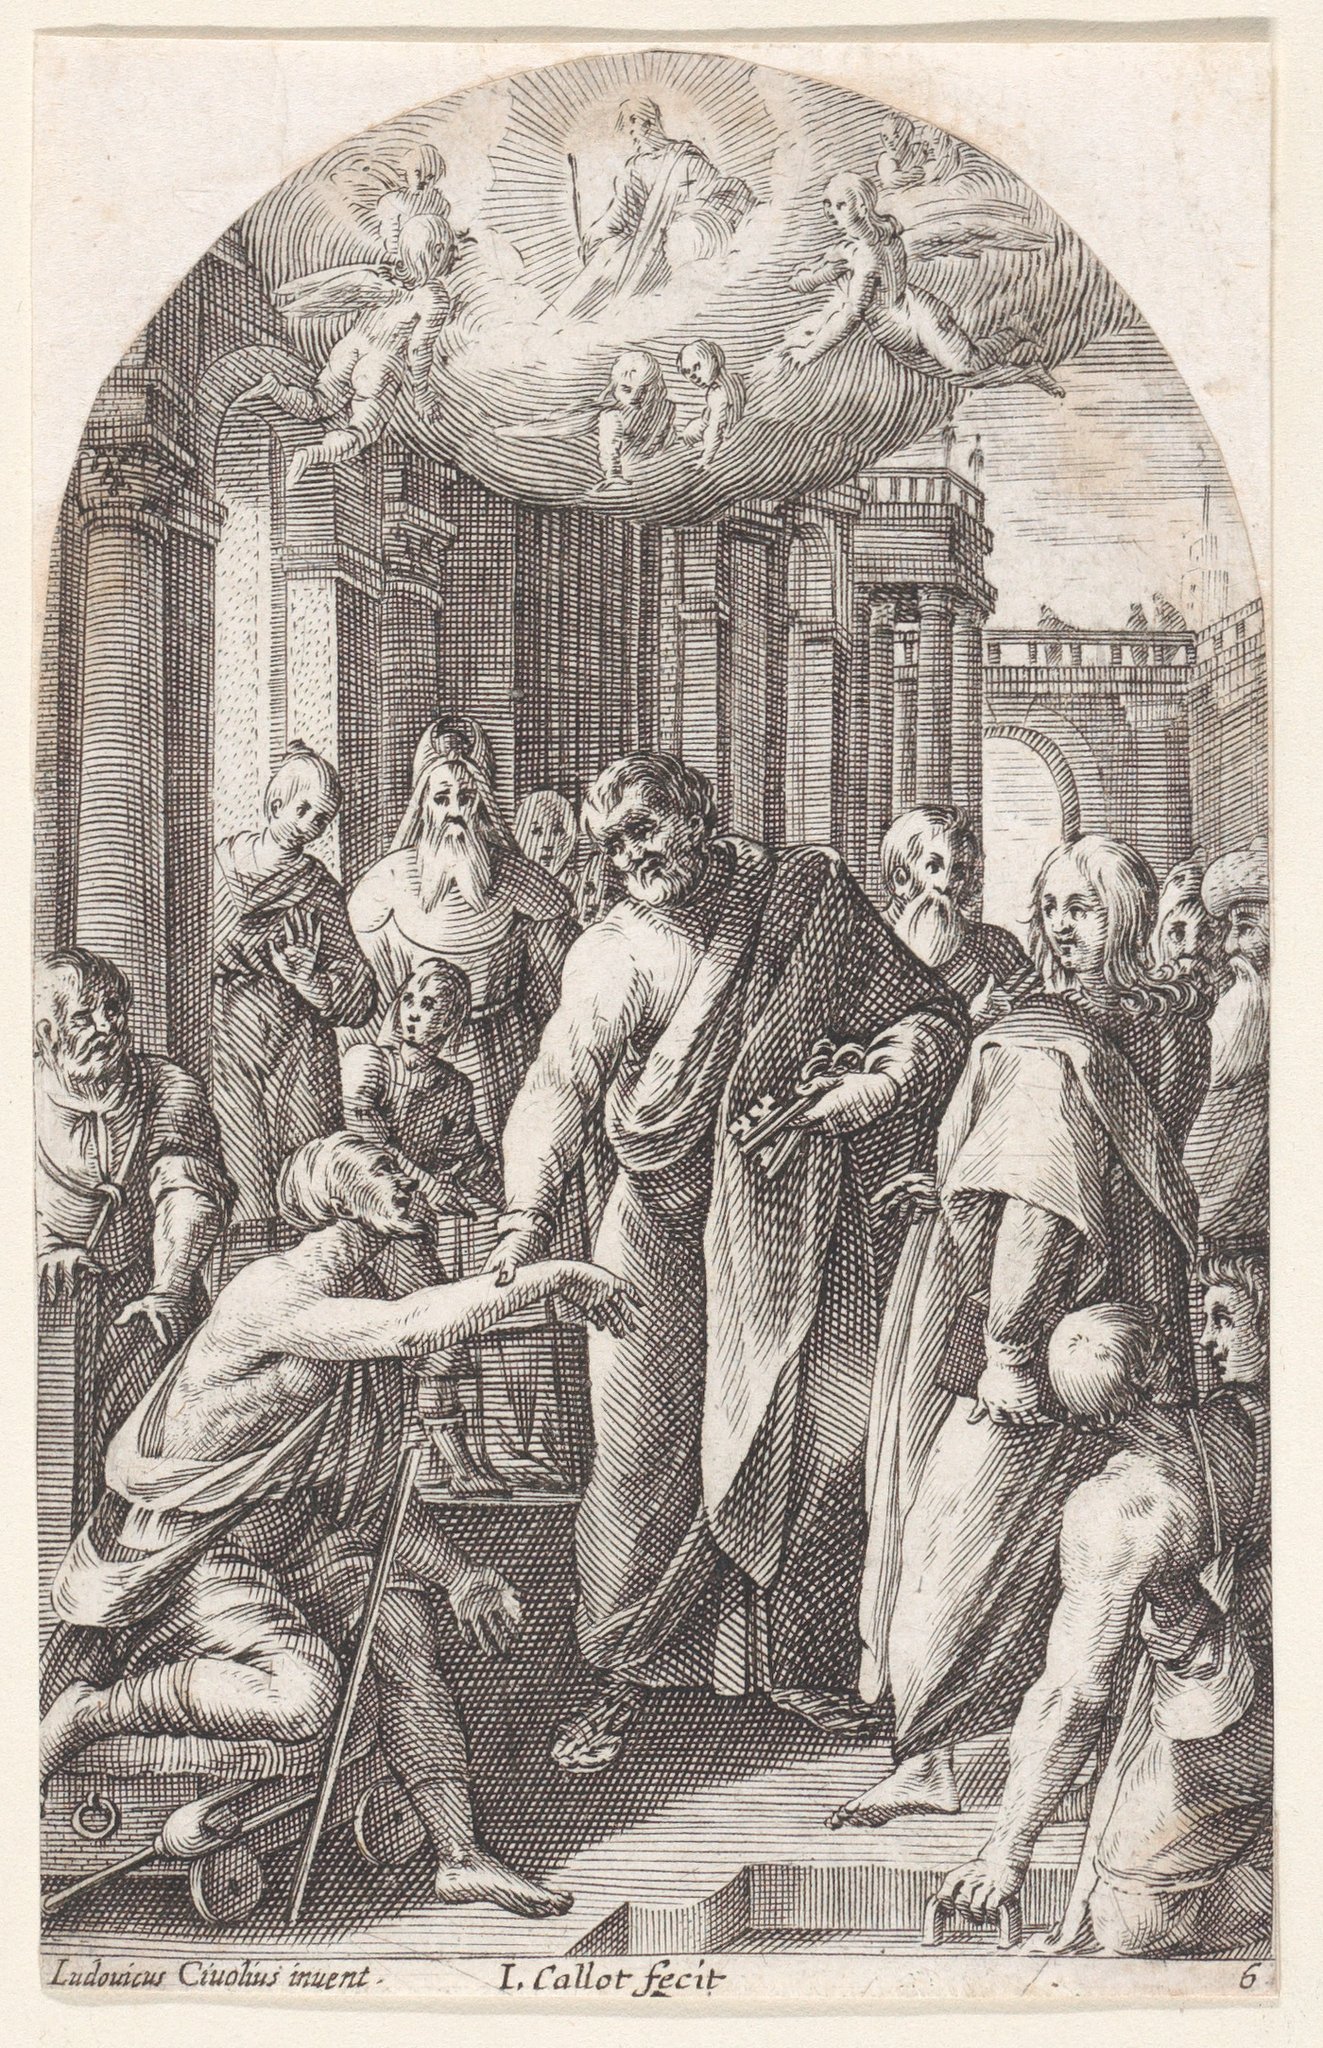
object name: print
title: St. Peter and St. John Healing the Lame at the Gates of the Temple, plate 6 from "Les Tableaux de Rome, Les Eglises Jubilaires" (The Paintings of Rome, The Churches Jubilee)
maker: jacques callot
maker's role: artist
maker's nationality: french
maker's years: 1592-1635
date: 1607-1611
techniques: engraving